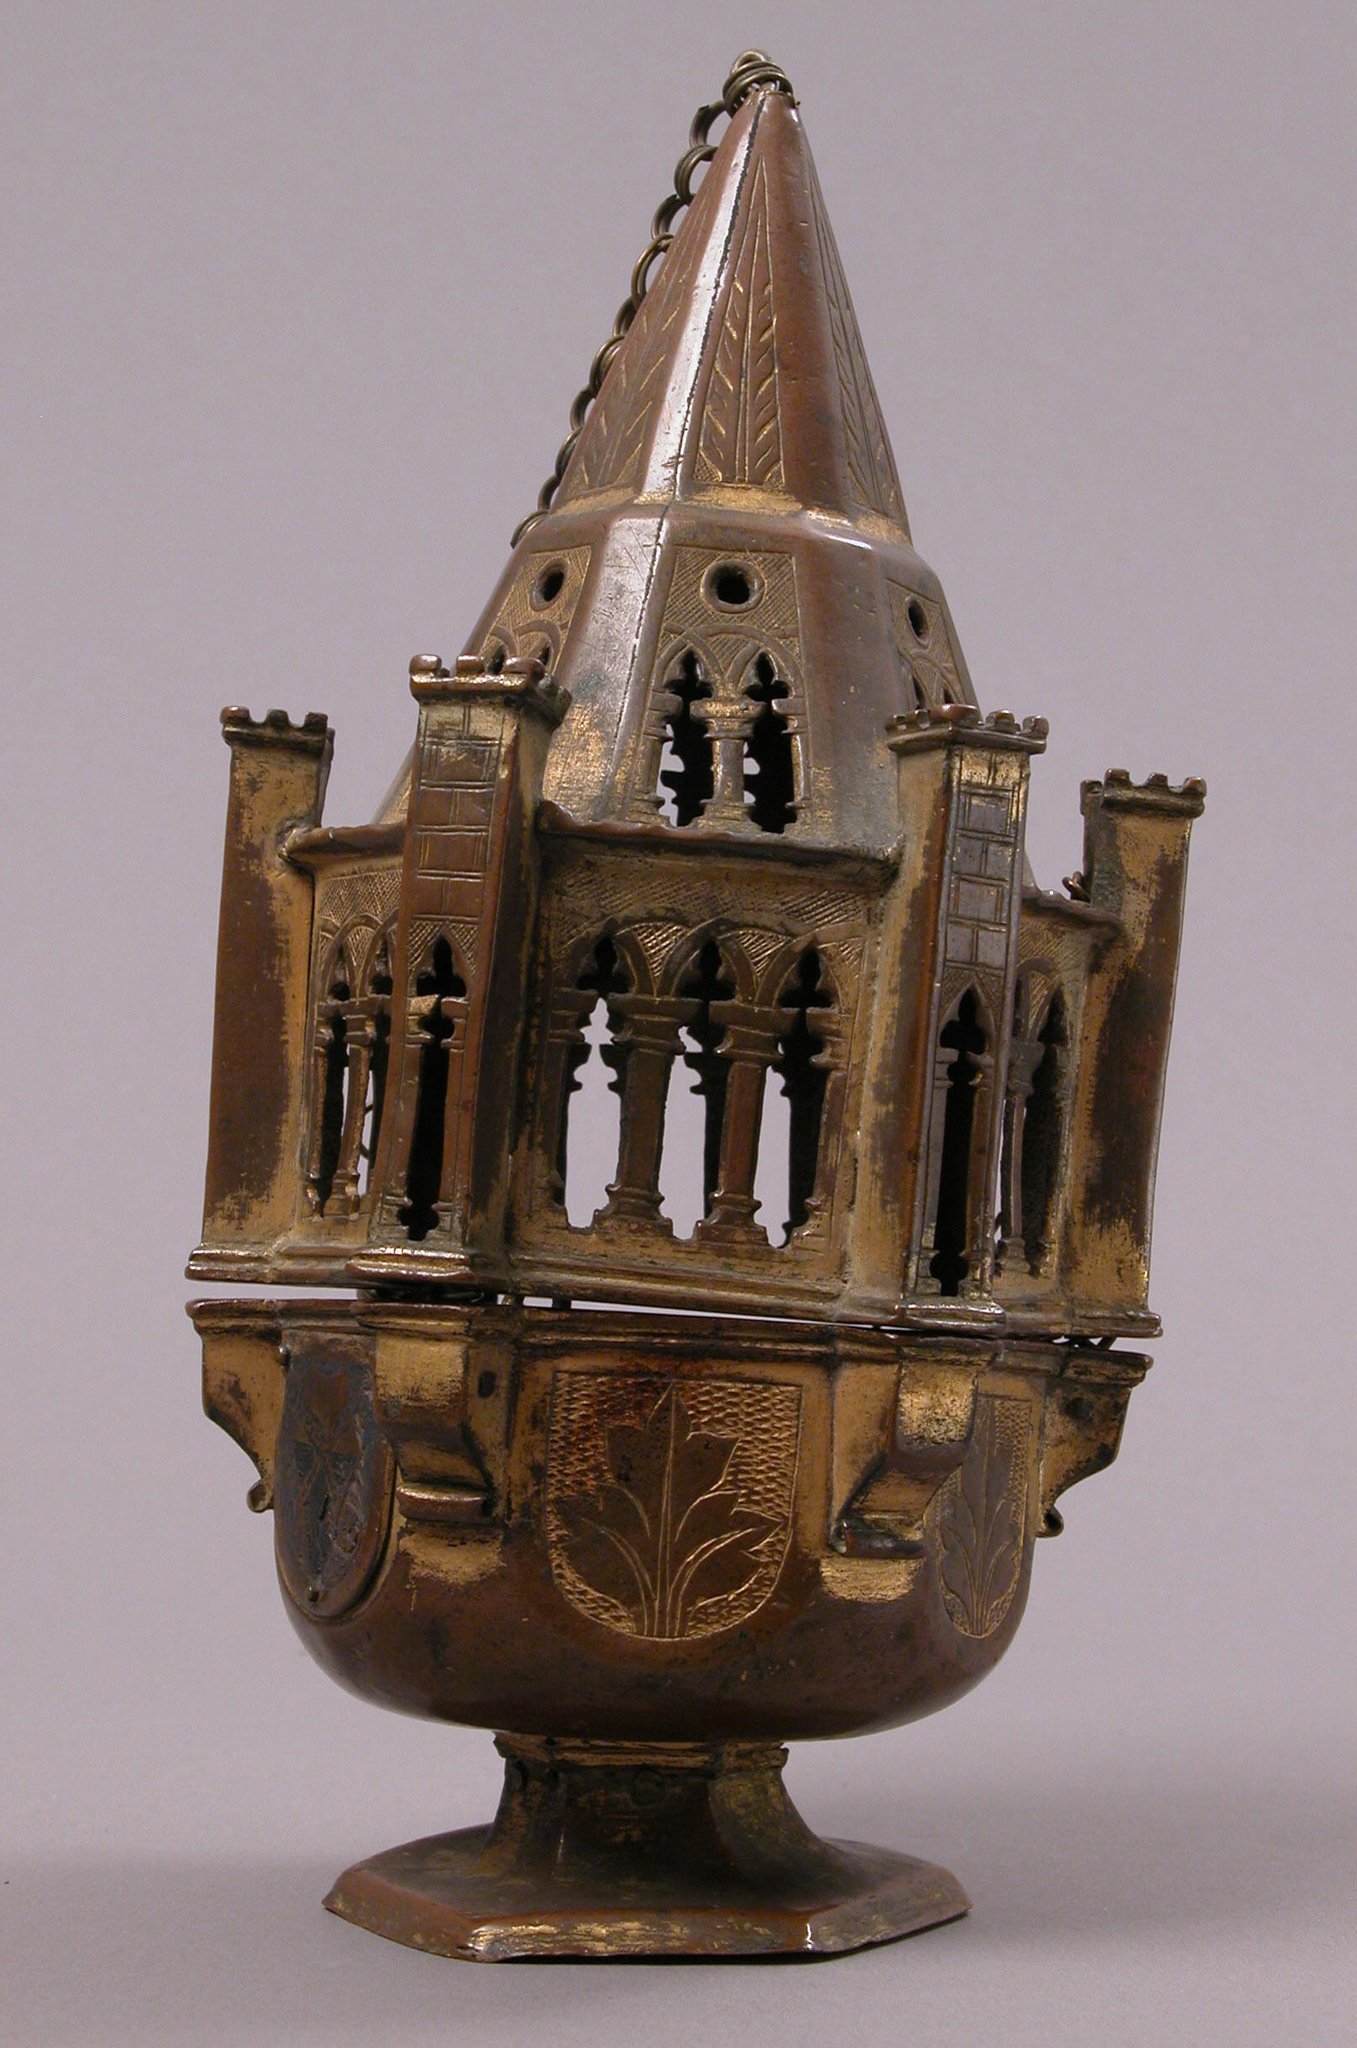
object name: censer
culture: italian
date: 1401-1500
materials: gilt copper, enamel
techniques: enamel